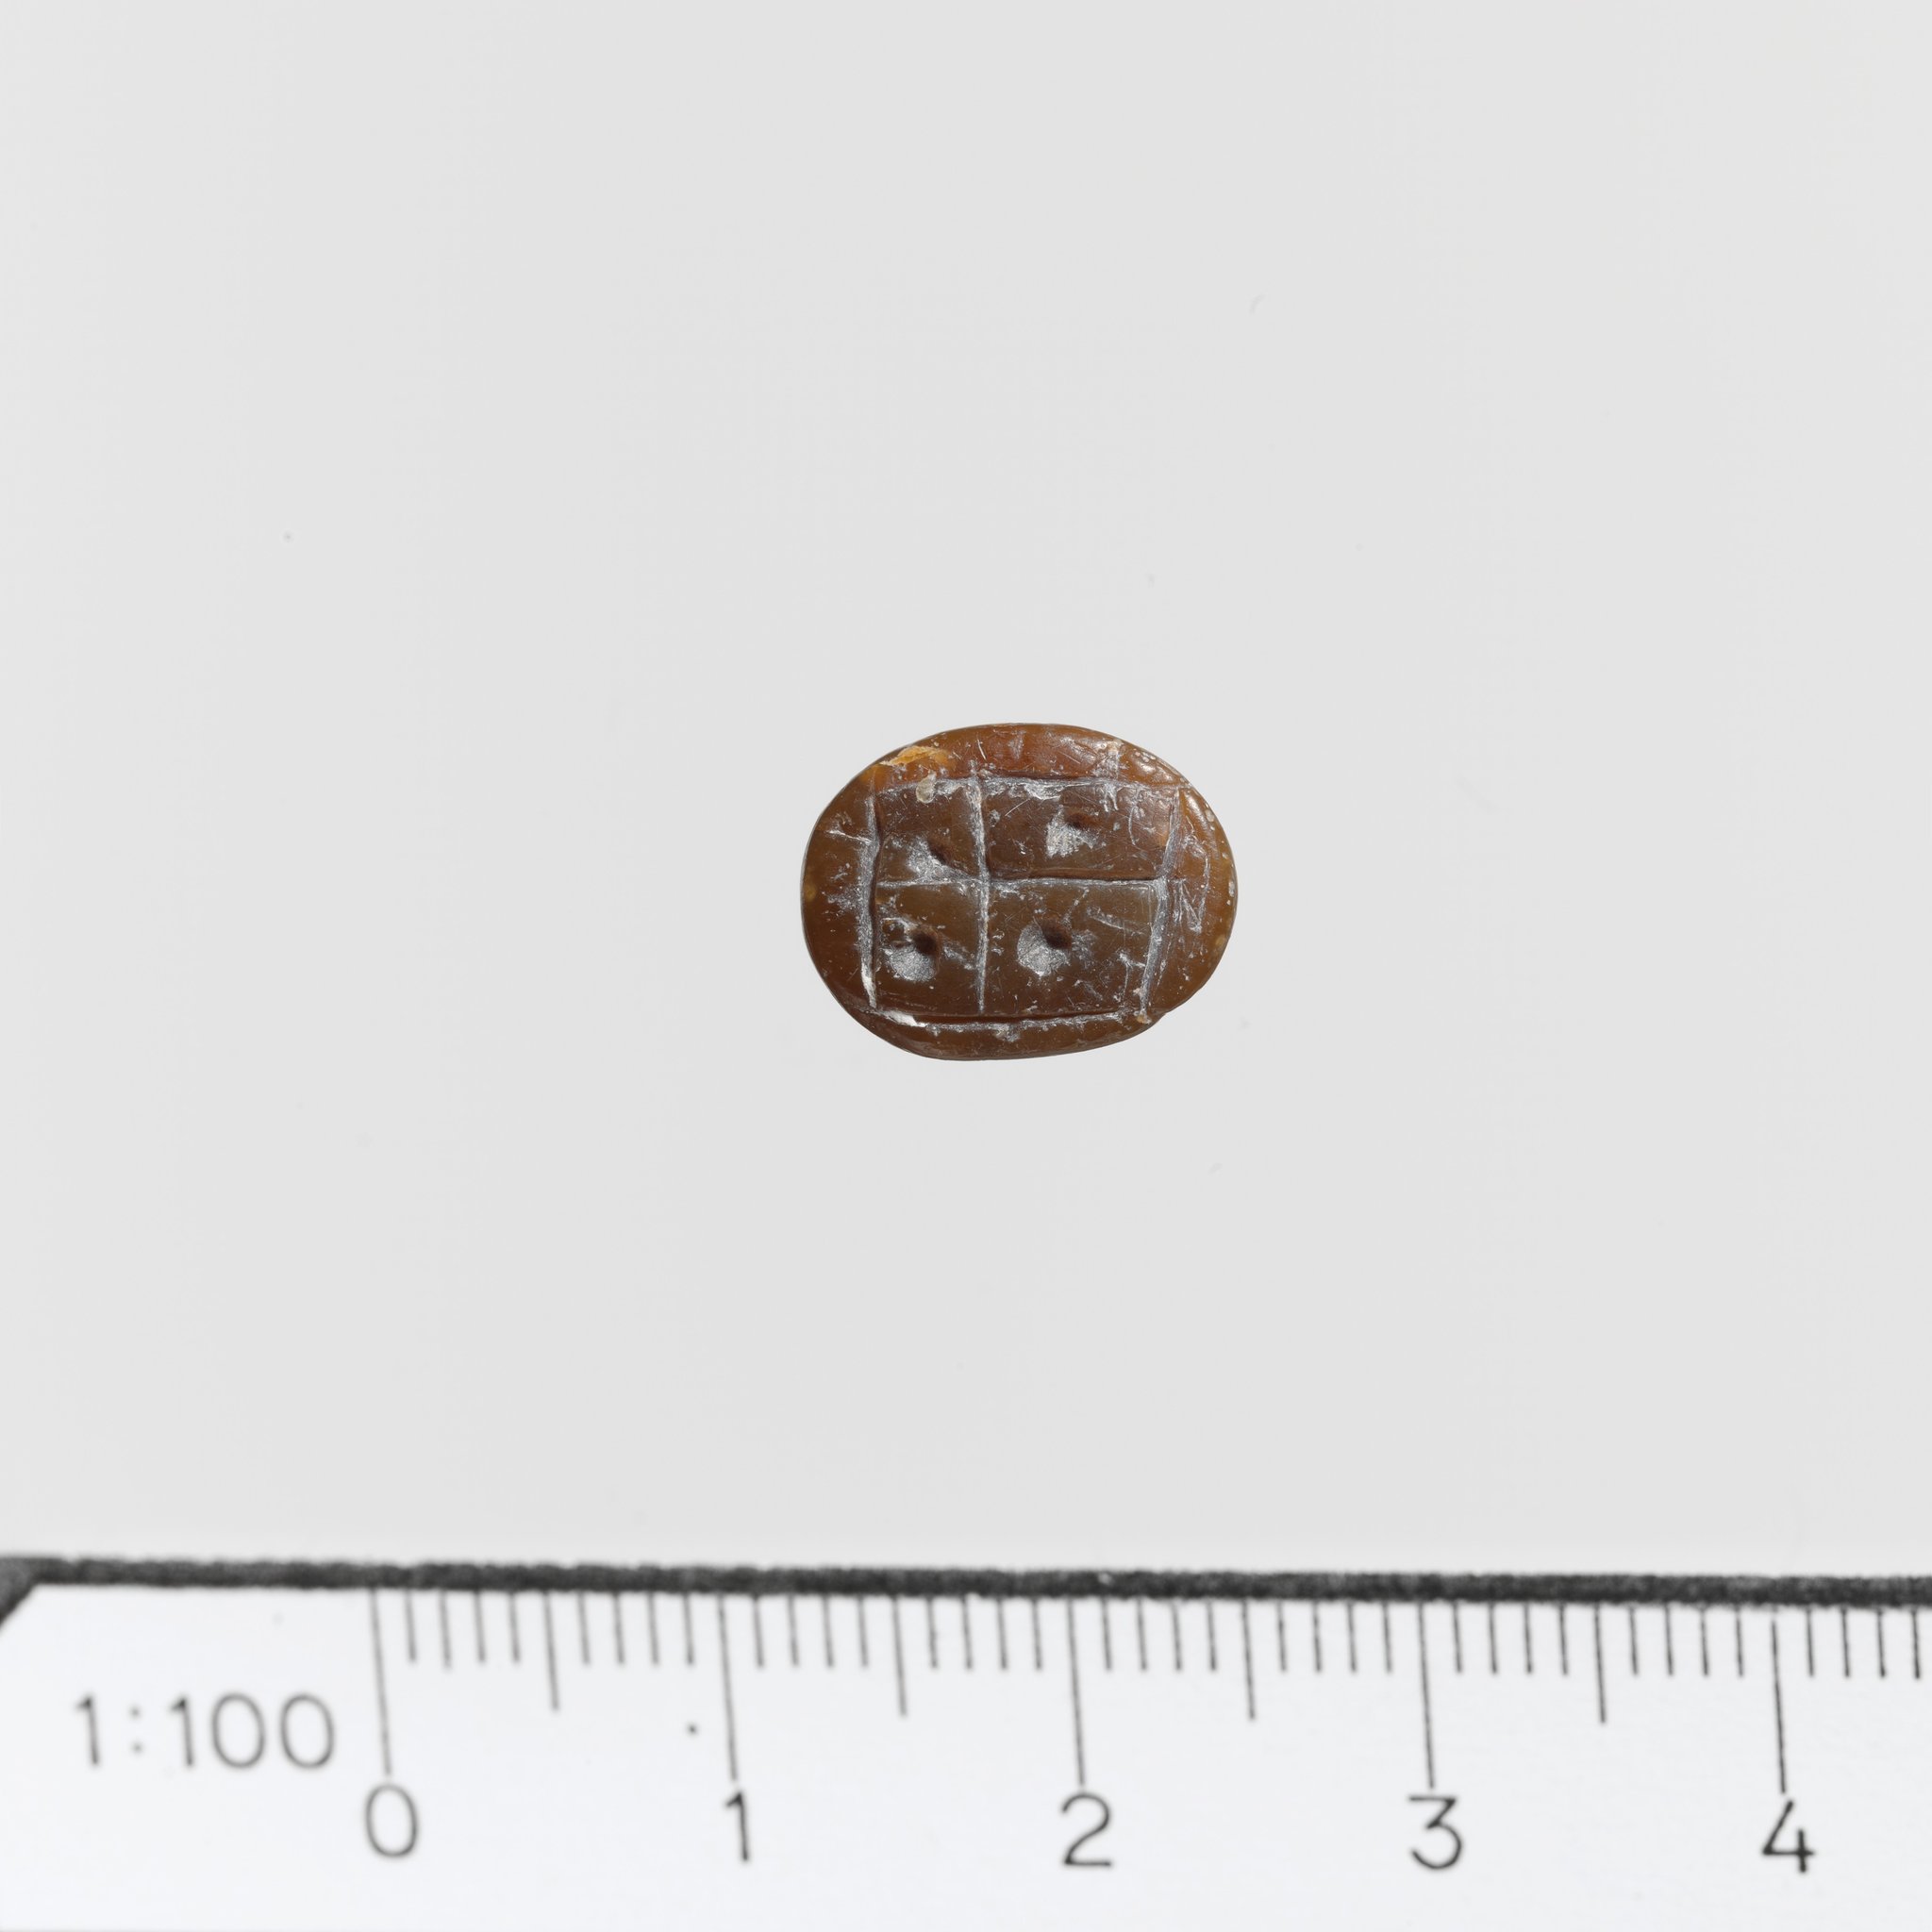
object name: seal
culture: minoan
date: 2600-2000 BCE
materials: stone